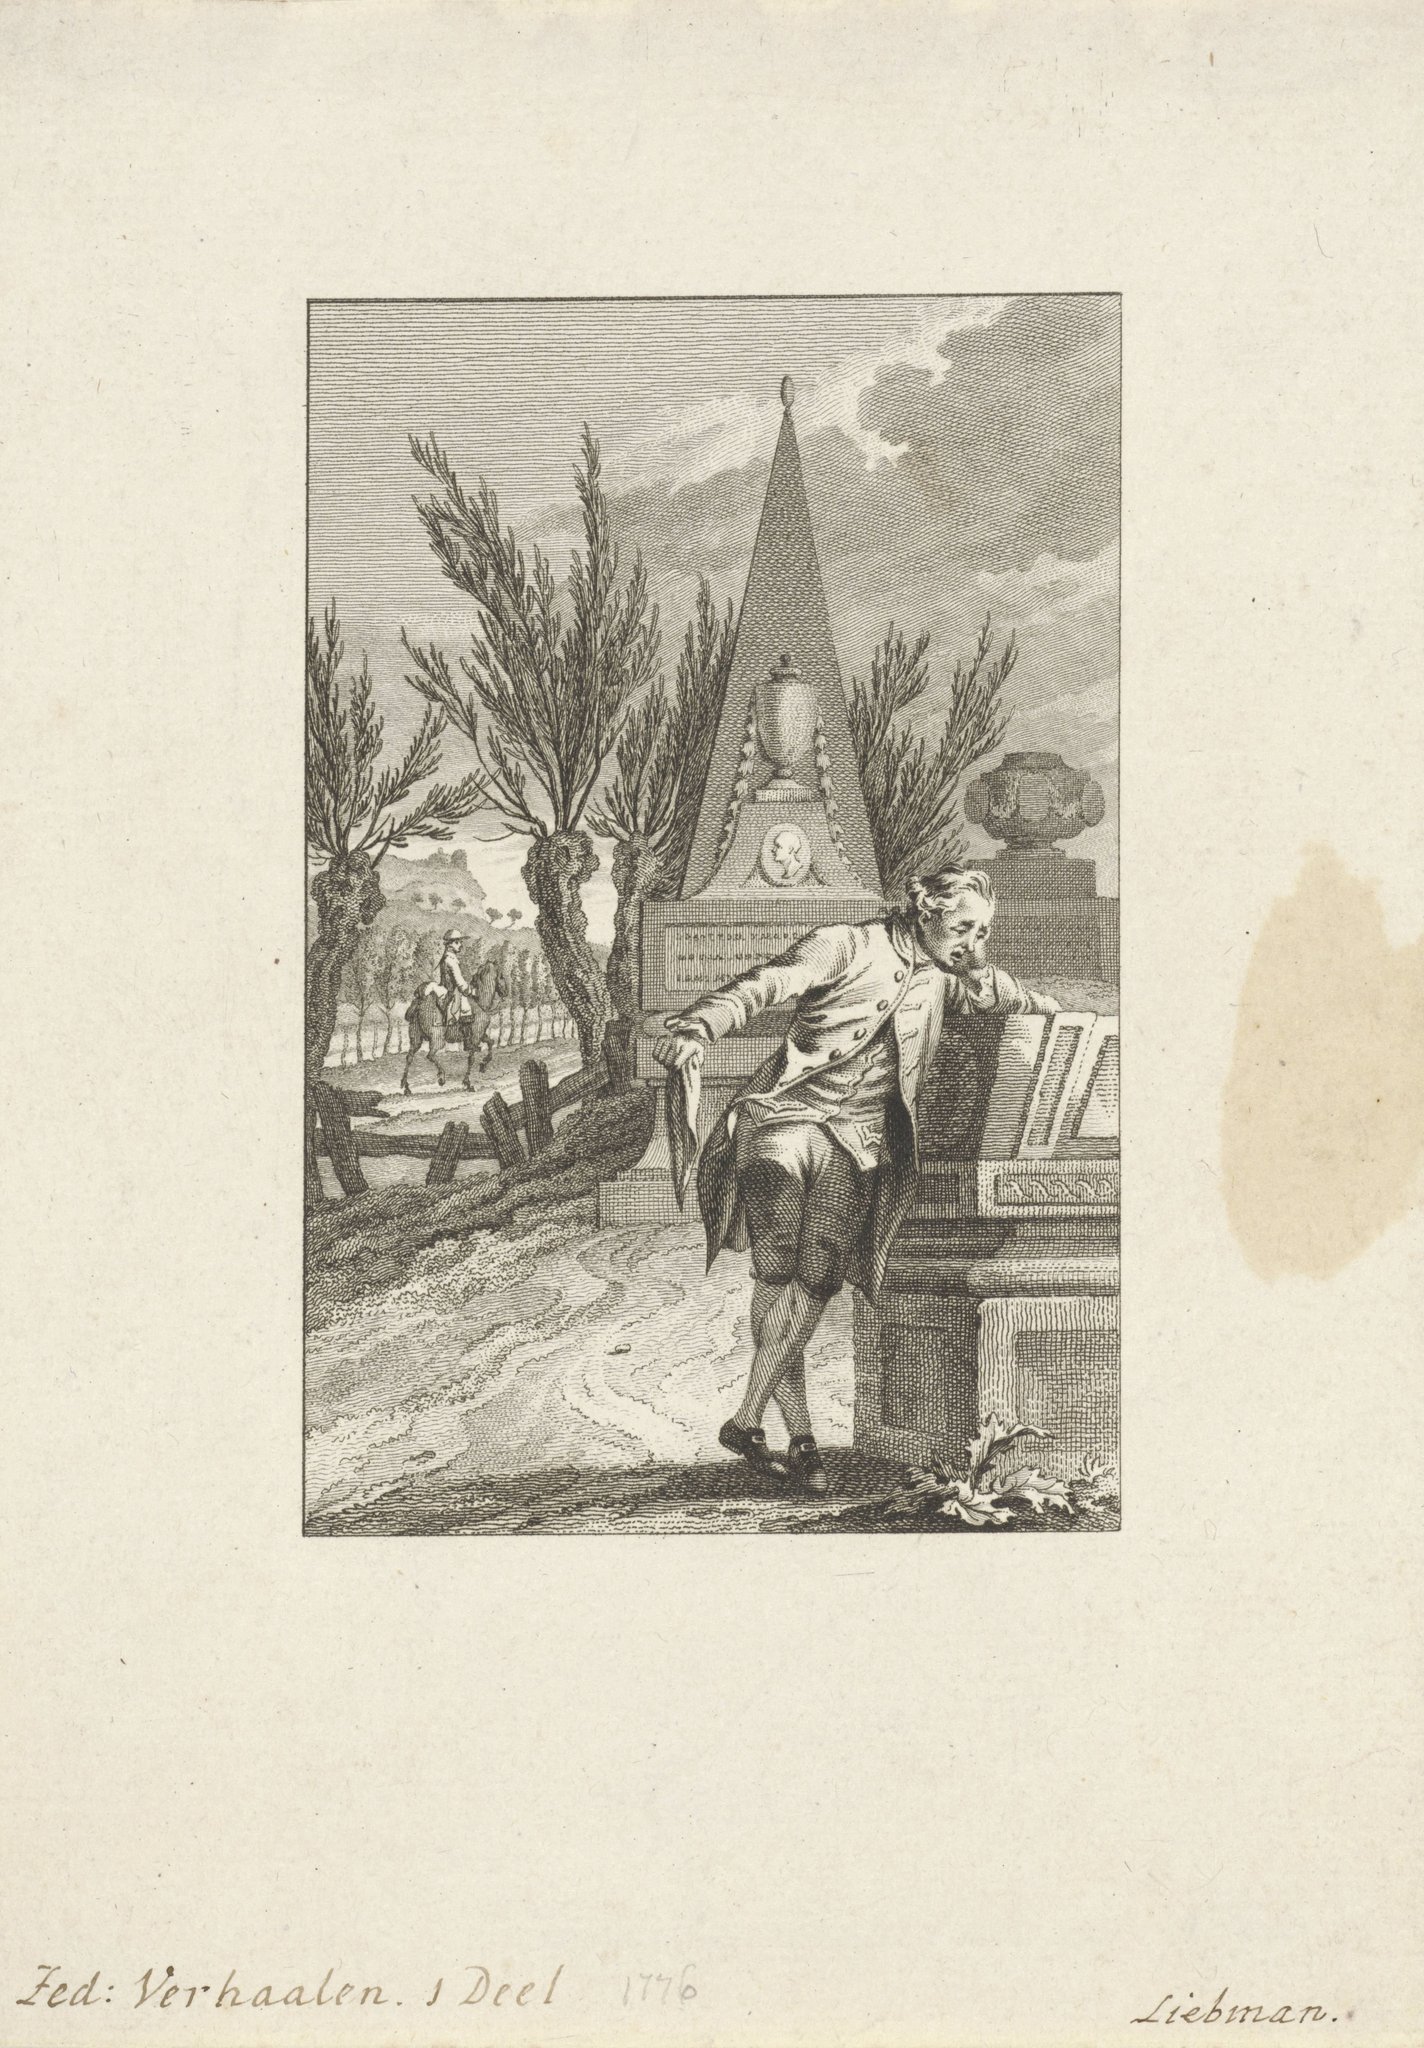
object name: print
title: Huilende man bij een graf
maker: reinier vinkeles (i)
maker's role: draughtsman, print maker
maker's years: 1741-1816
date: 1751-1816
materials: paper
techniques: engraving, etching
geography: amsterdam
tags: grave, tomb, mourning the dead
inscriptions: collector's mark: Lugt 2228